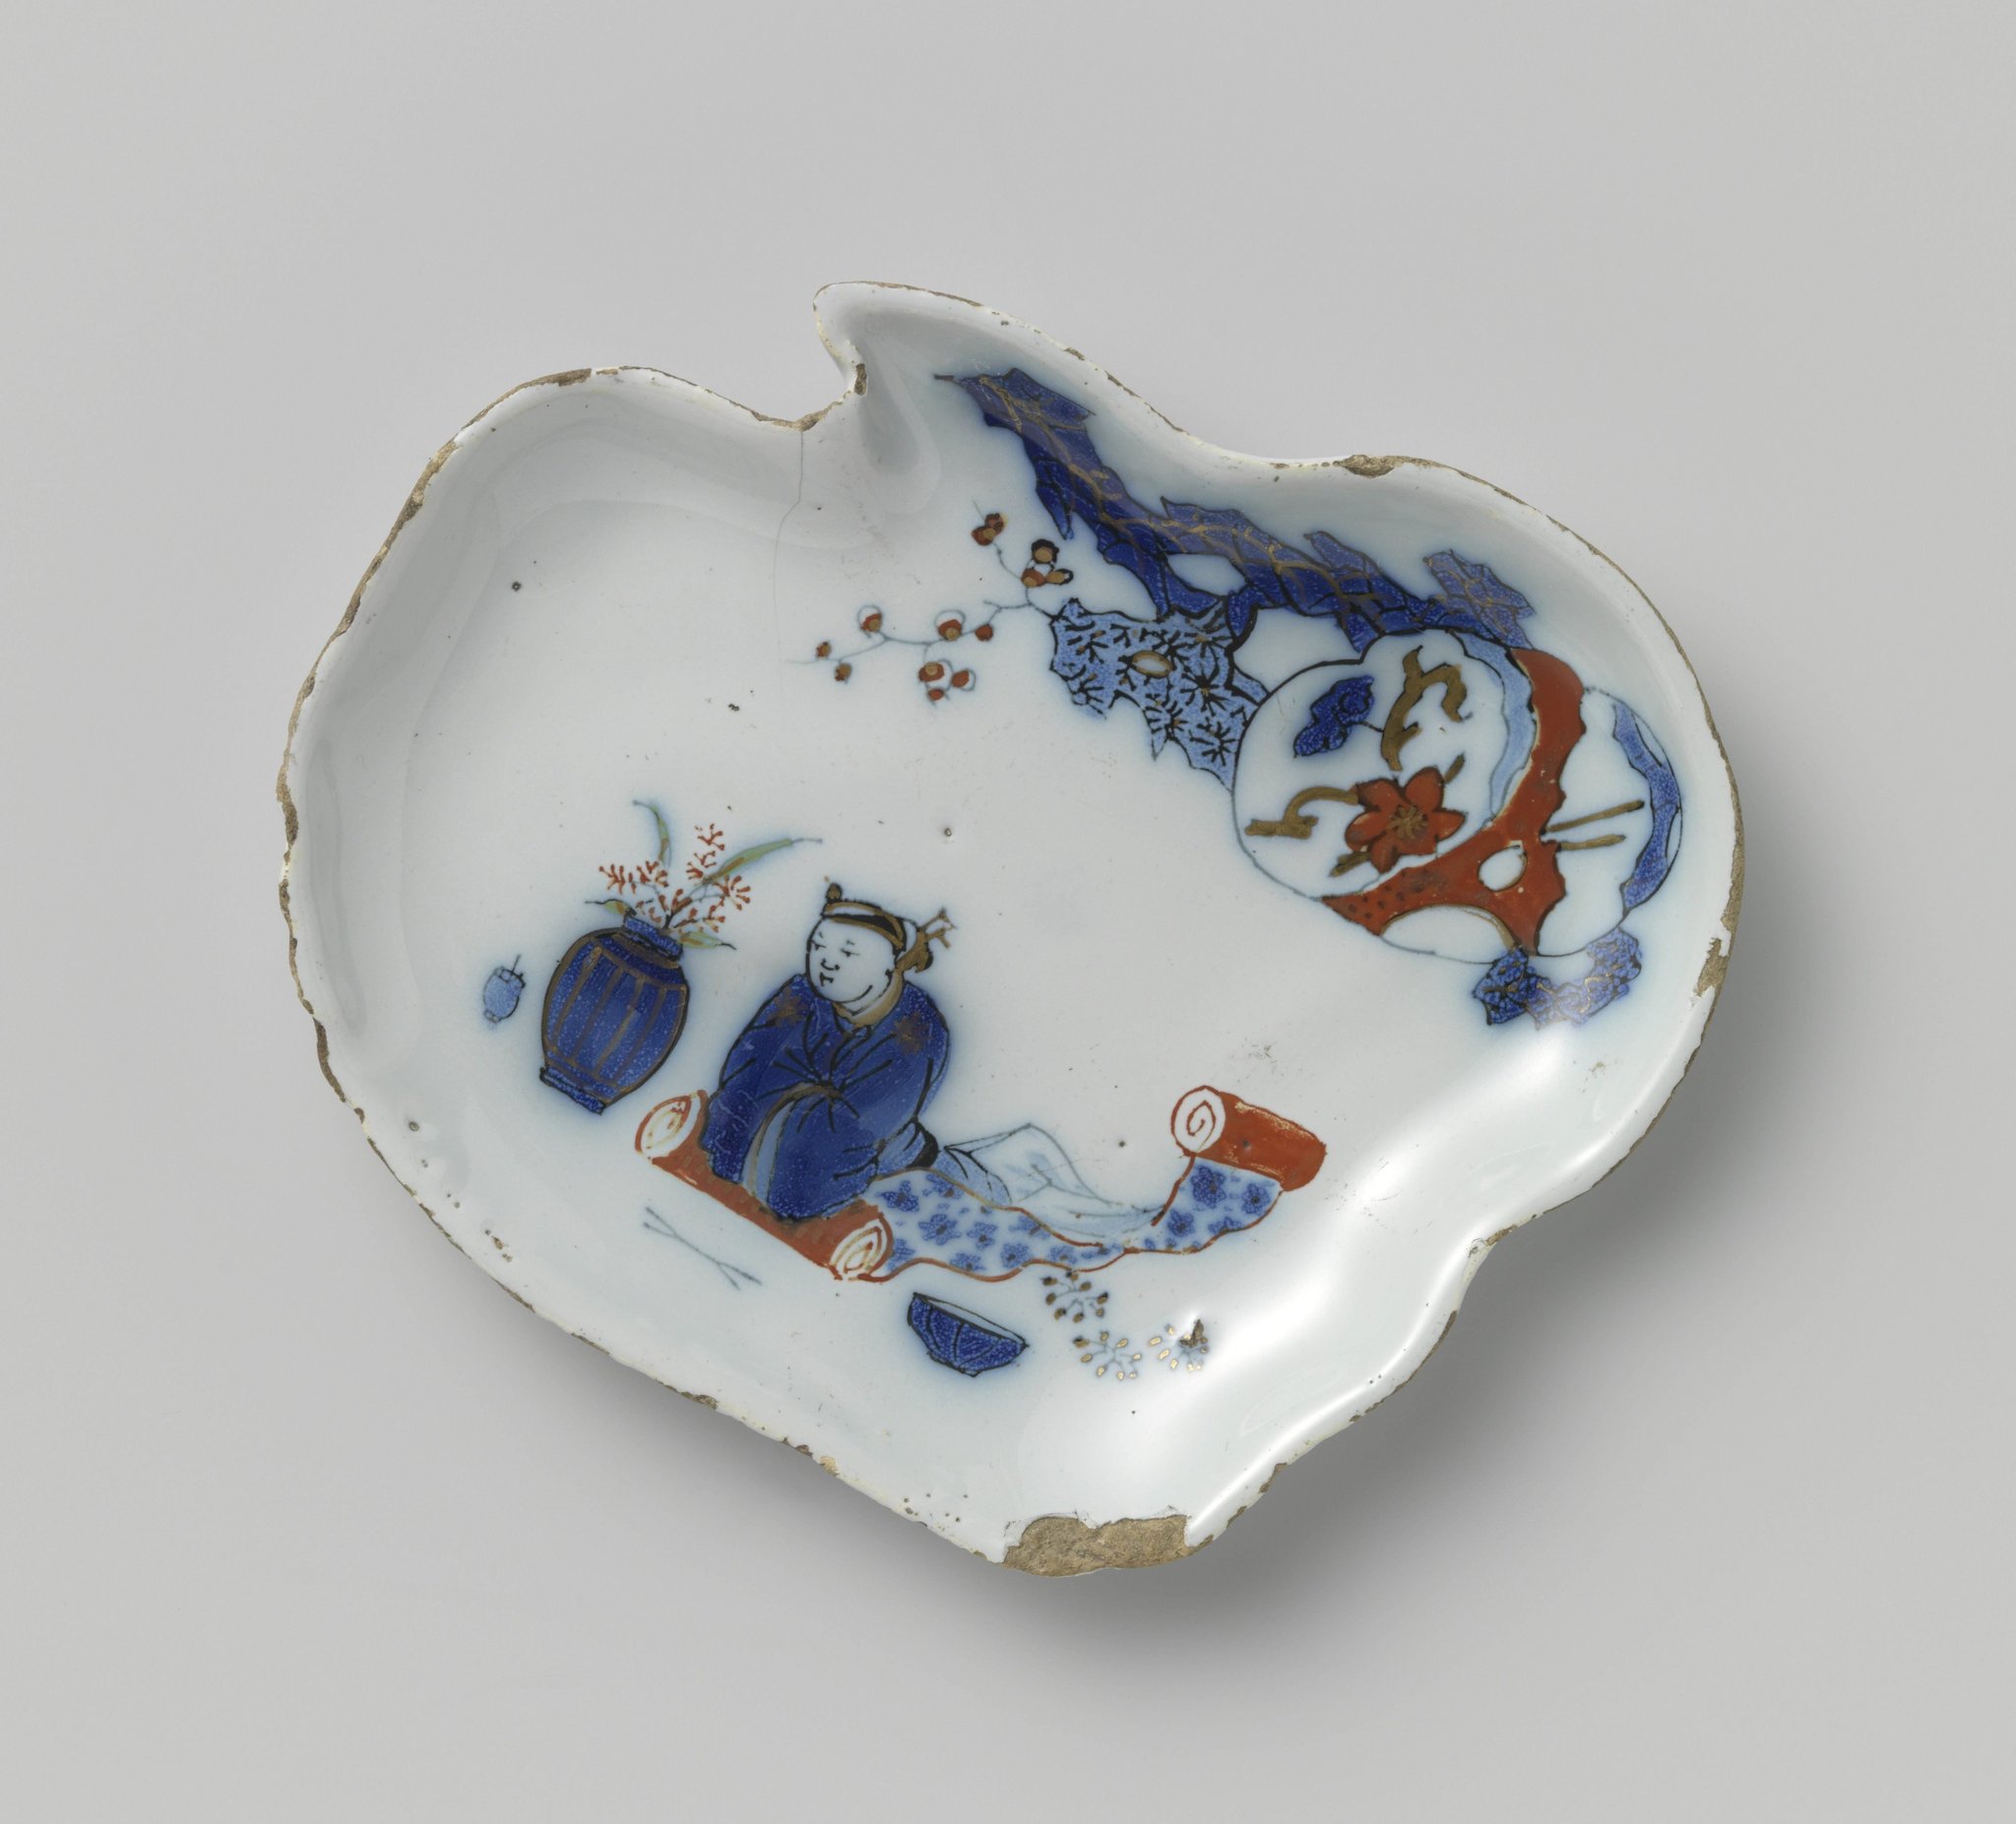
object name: dish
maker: rochus jacobsz. hoppesteijn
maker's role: plateelbakker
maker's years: -1692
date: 1685-1690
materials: earthenware, glaze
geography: delft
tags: chinese (+ other cultural aspects)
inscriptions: mark: ‘RIHS(ineen)’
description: The leaf shape of this small dish was inspired by ko-sometsuke, porcelain produced in China in a great variety of forms in the early 17th century especially for the Japanese market. The decorations on it do not coincide with the leafshape. The Delft painter made them up, basing himself on Asian porcelain.